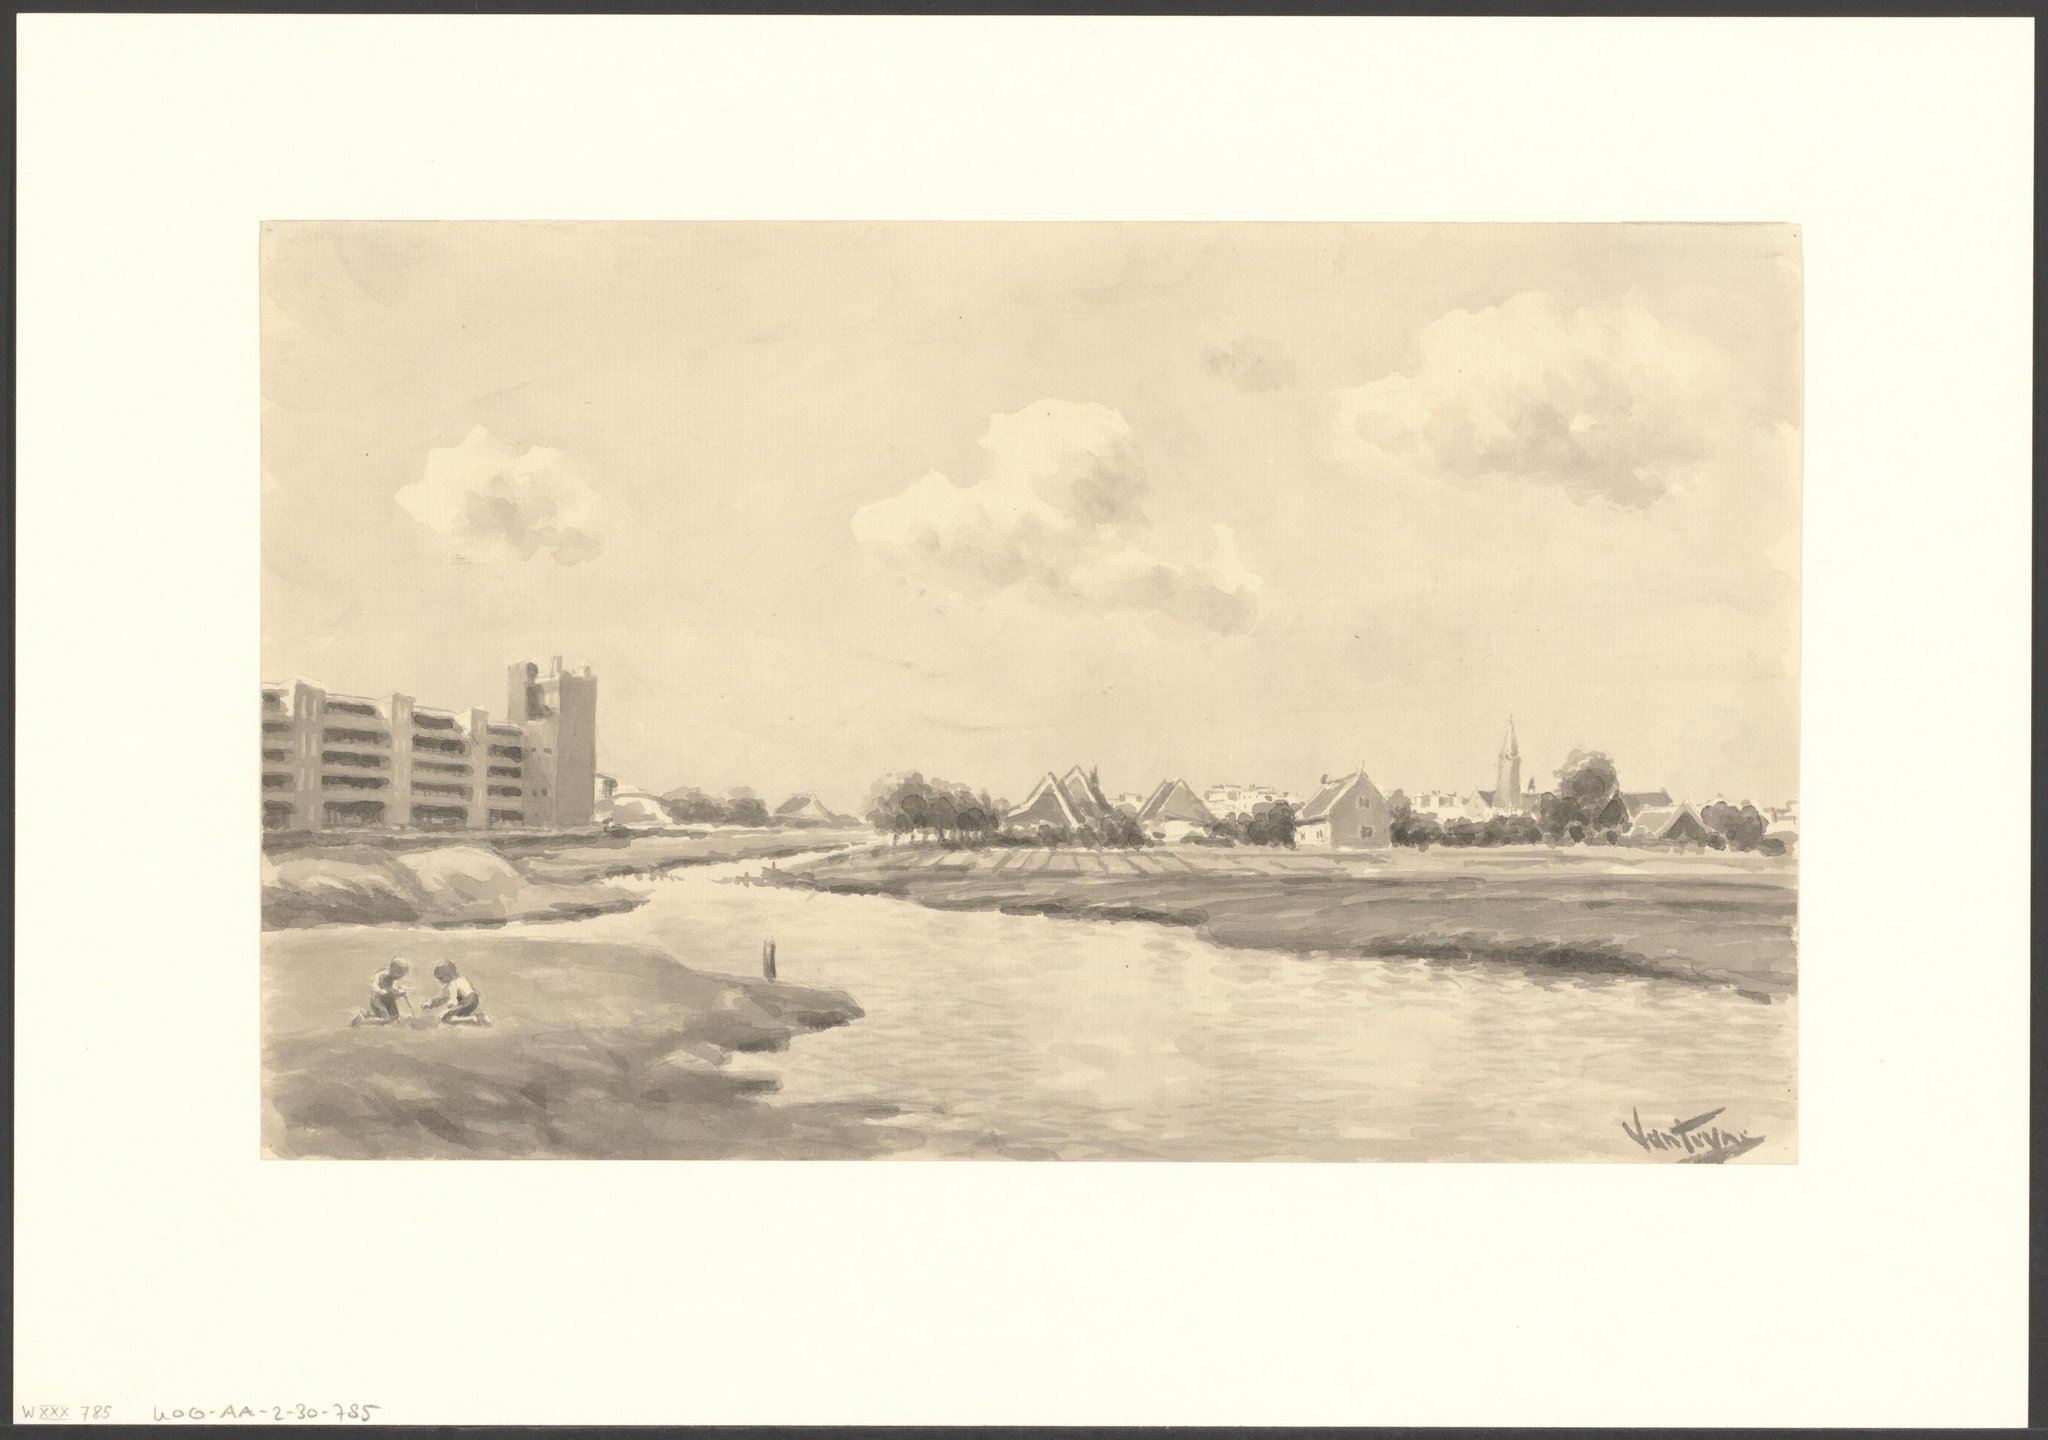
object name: drawing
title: Gezicht op de Warmoestuinen vanaf de Jan van Galenstraat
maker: anthonie van teijn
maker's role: draughtsman, painter, print maker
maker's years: 1863-1943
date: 1910-1927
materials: ink, paper, pencil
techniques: brush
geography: amsterdam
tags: city-view in general; 'veduta', canal, the usual house or row of houses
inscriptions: inscription: ‘Warmoezierstuinen gezien van (...) Oct 1927 / vanEck’, collector's mark: Lugt 800a, signature: ‘VanTeyne’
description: Tekening binnen de Atlas Van Eck ingedeeld op wijknummer 30.